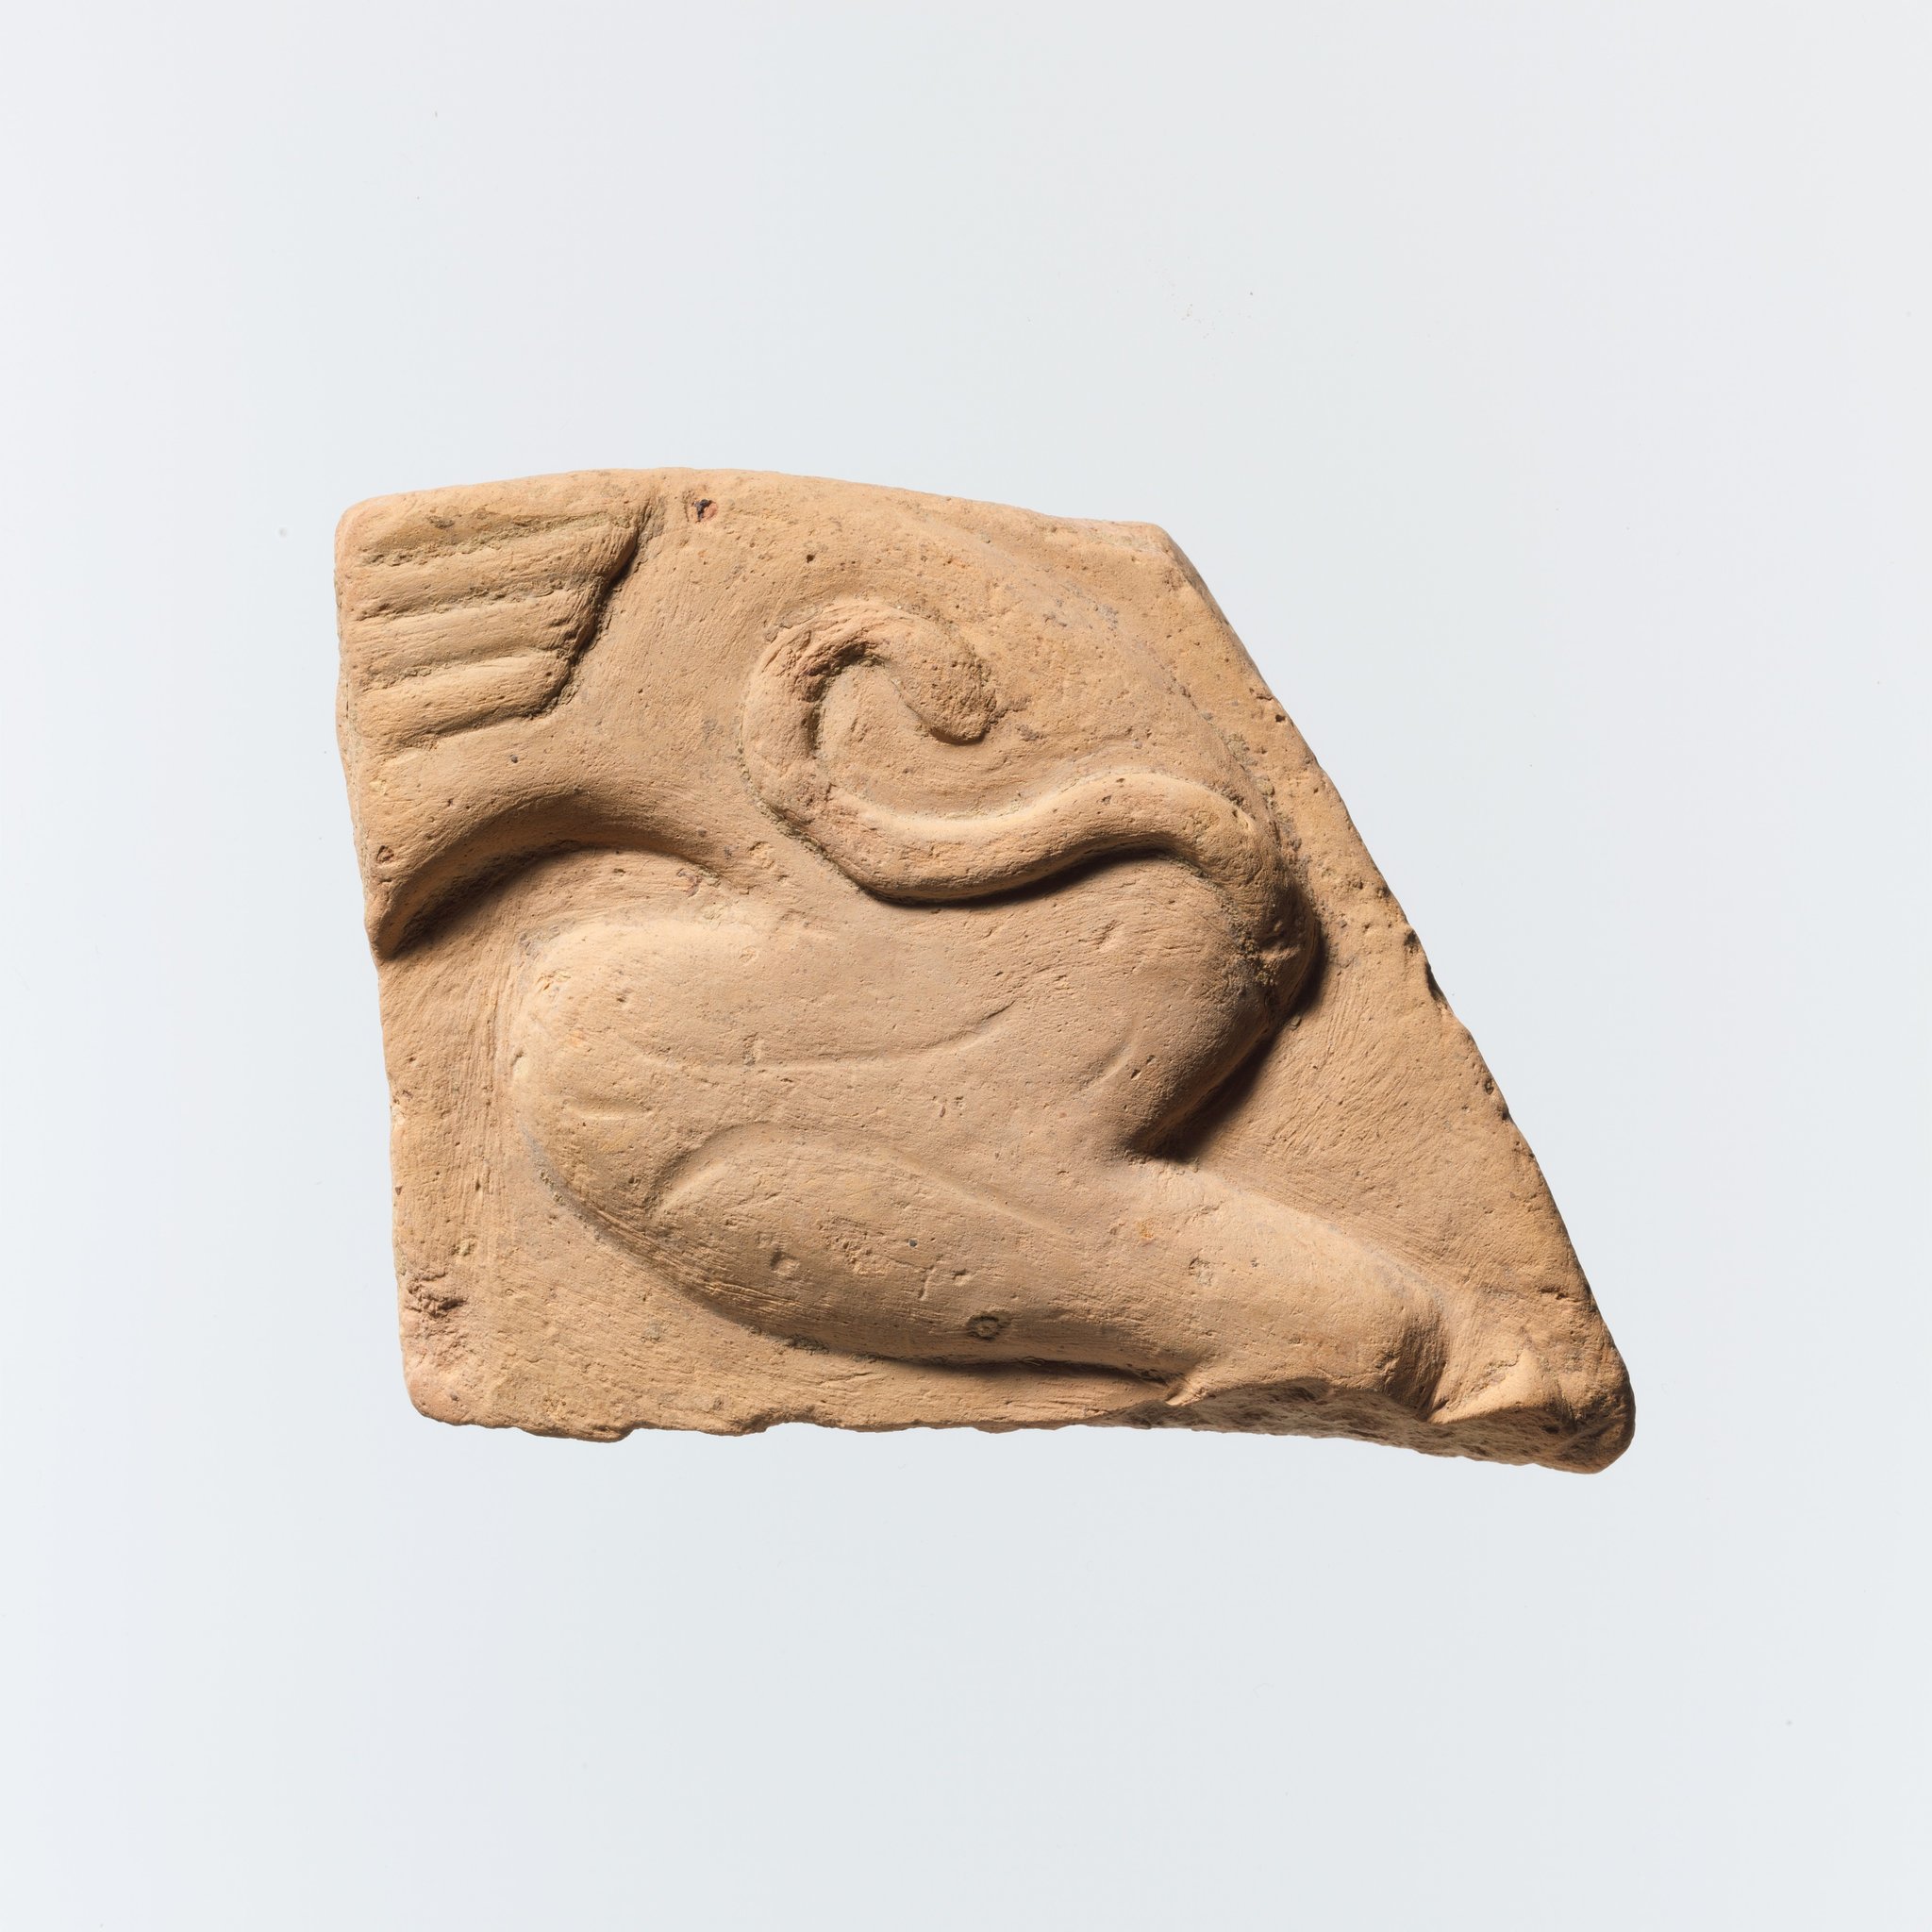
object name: pinax, griffin or sphinx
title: Fragment of a terracotta plaque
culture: greek, cretan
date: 600-501 BCE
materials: terracotta